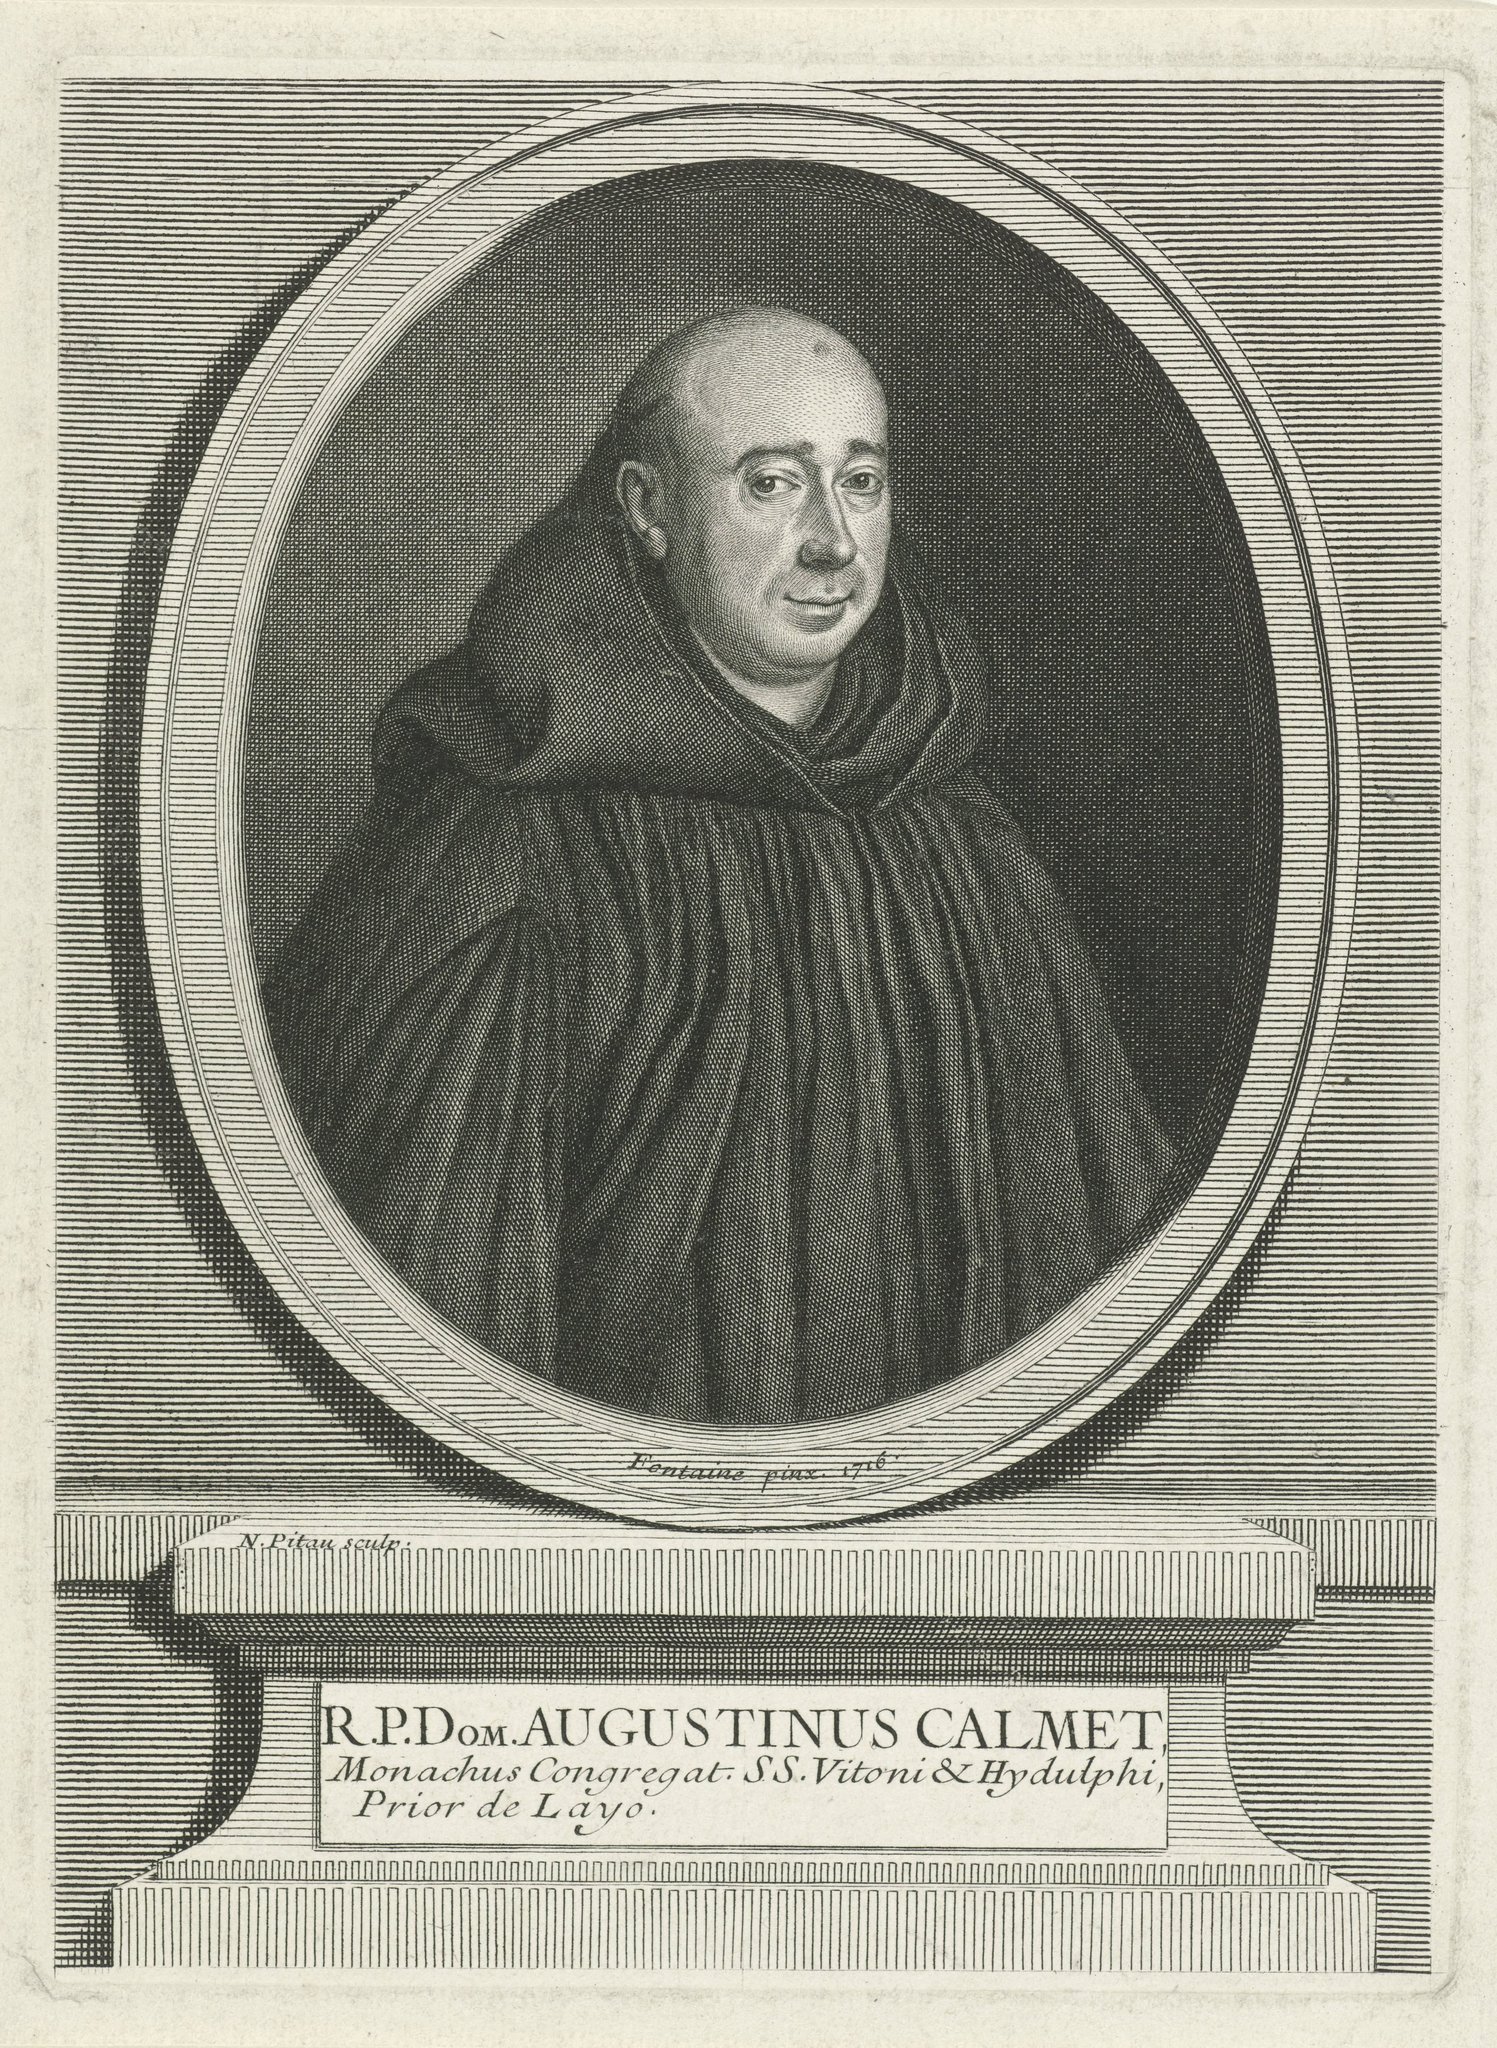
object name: print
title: Portret van de theoloog Augustin Calmet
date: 1716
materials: paper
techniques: engraving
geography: paris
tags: habit, frock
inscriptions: collector's mark: Lugt 2228